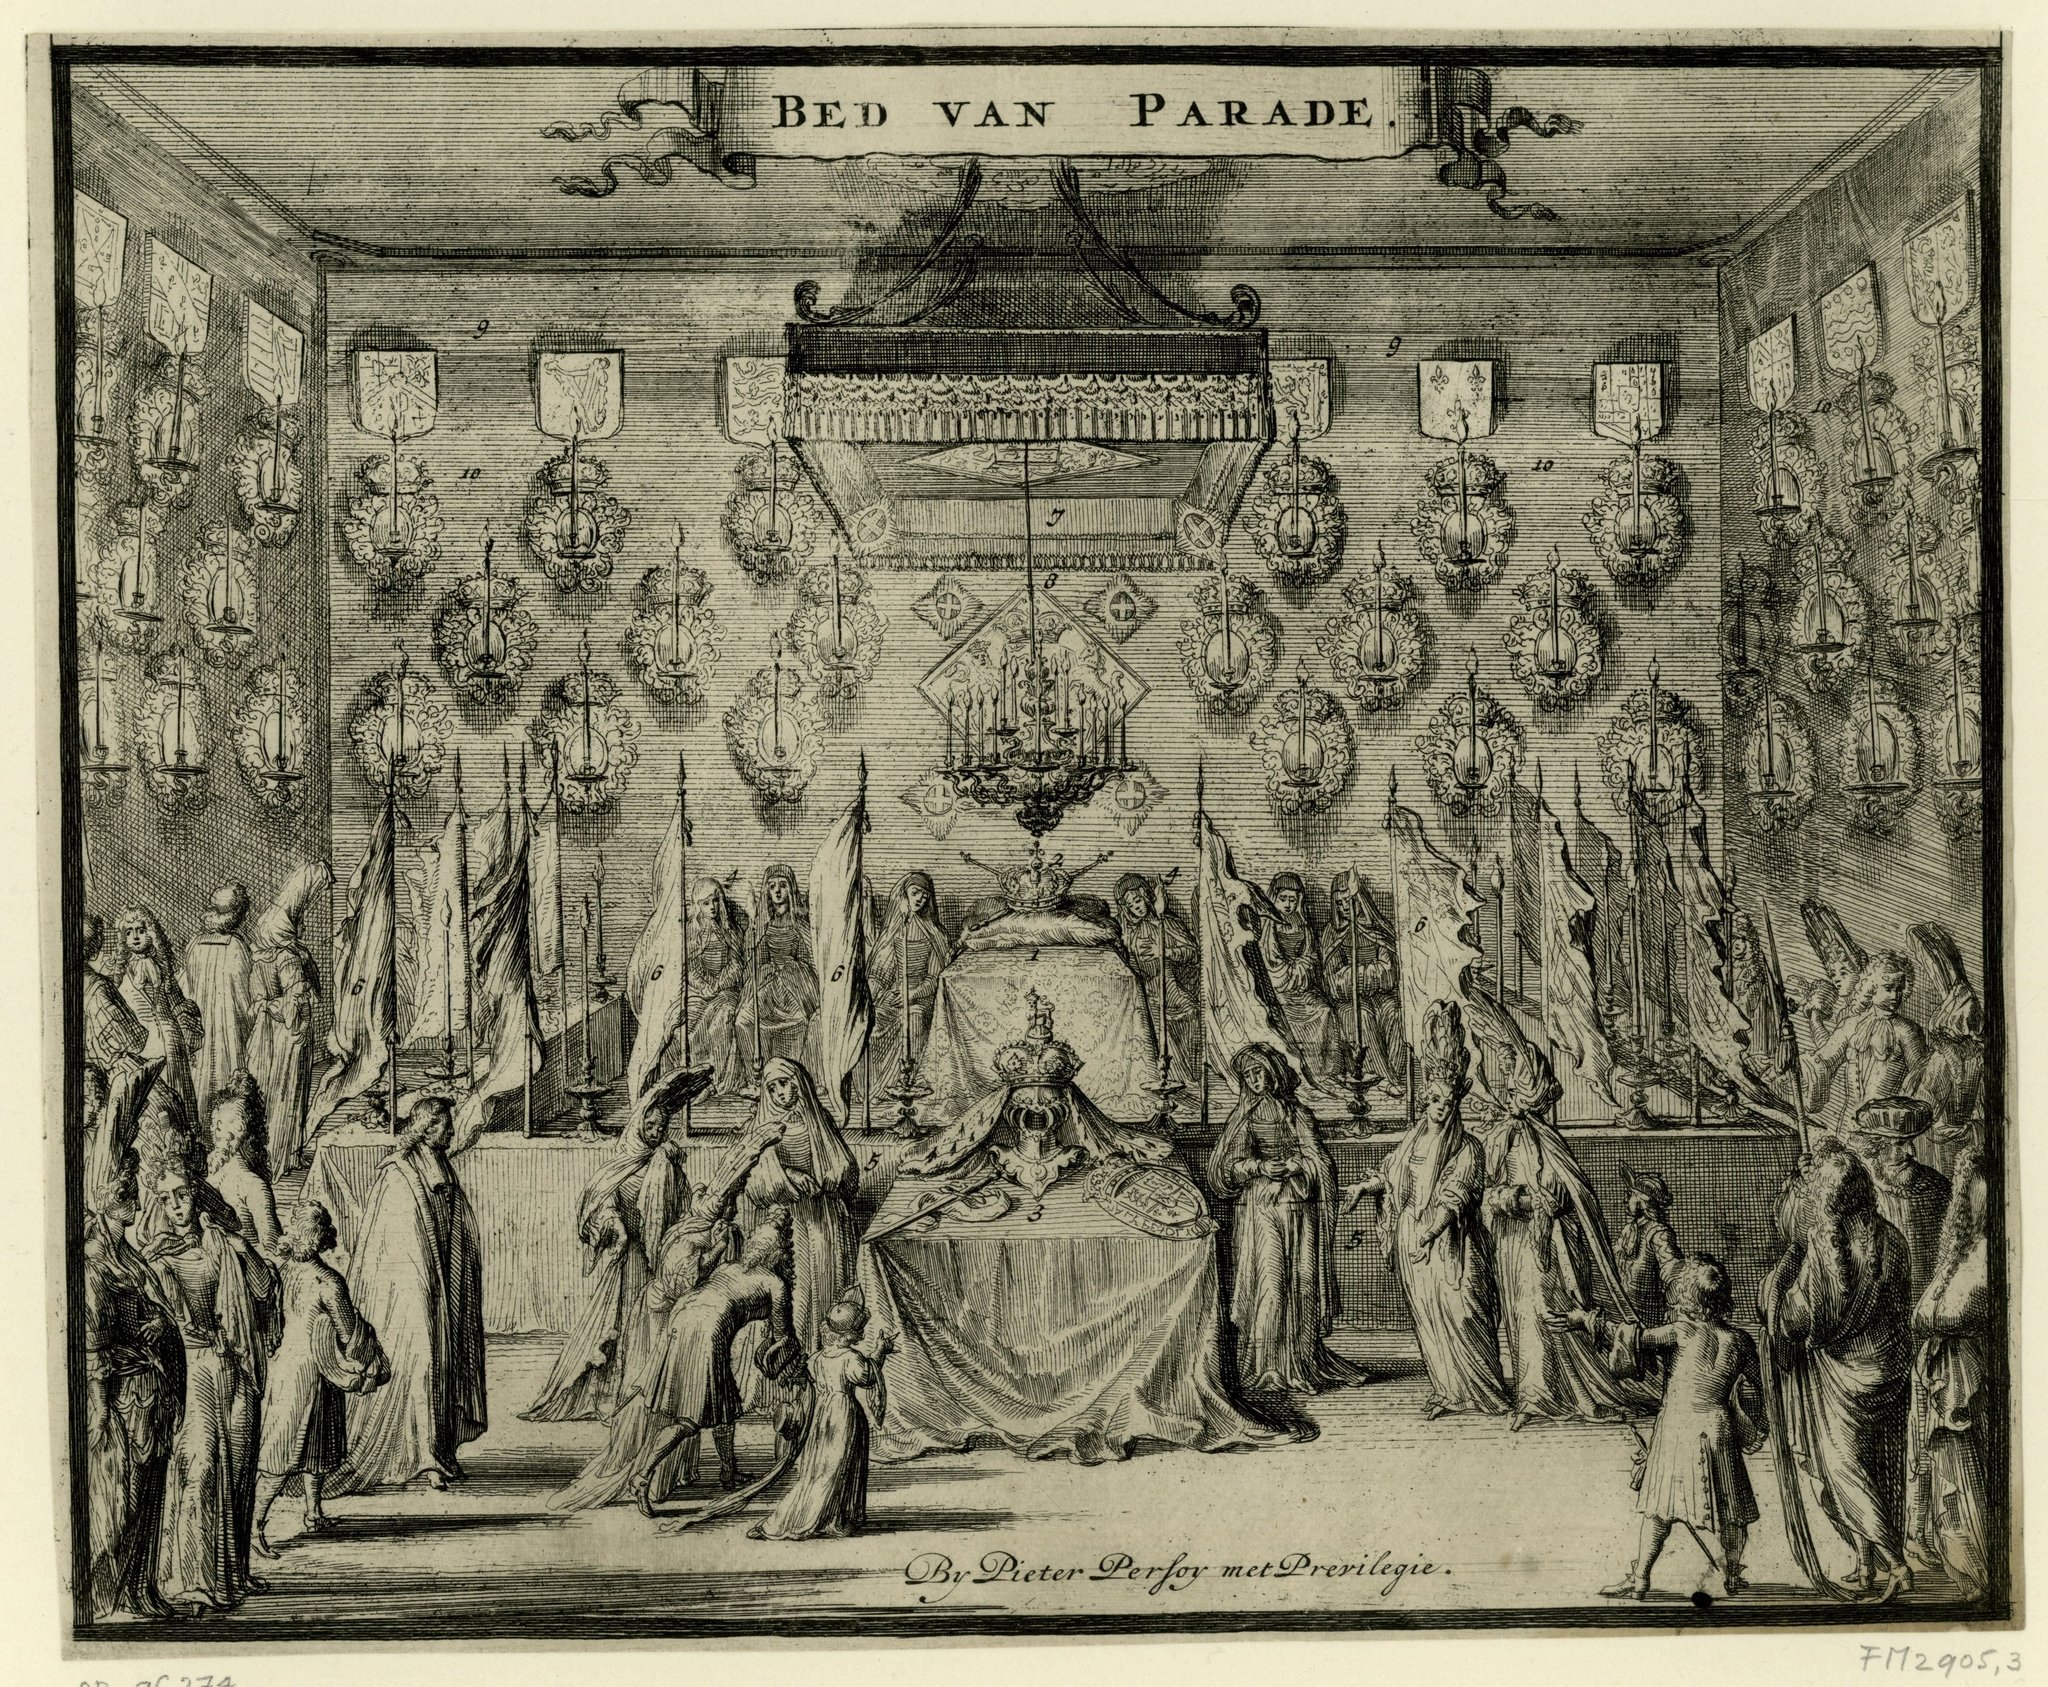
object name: print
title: Het overlijden en de lijkstatie van Maria II Stuart, koningin van Engeland, 1695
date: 1695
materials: paper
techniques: etching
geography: amsterdam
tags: london, maria ii stuart (koningin van engeland, schotland en ierland), bed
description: Interieur waarin het sterfbed van de koningin van Engeland staat opgesteld. Aan de muren brandende kaarsen. De prent is als illustratie gebruikt in Samuel Gruterus, Funeralia Mariae II Britanniarum, Haarlem 1695.